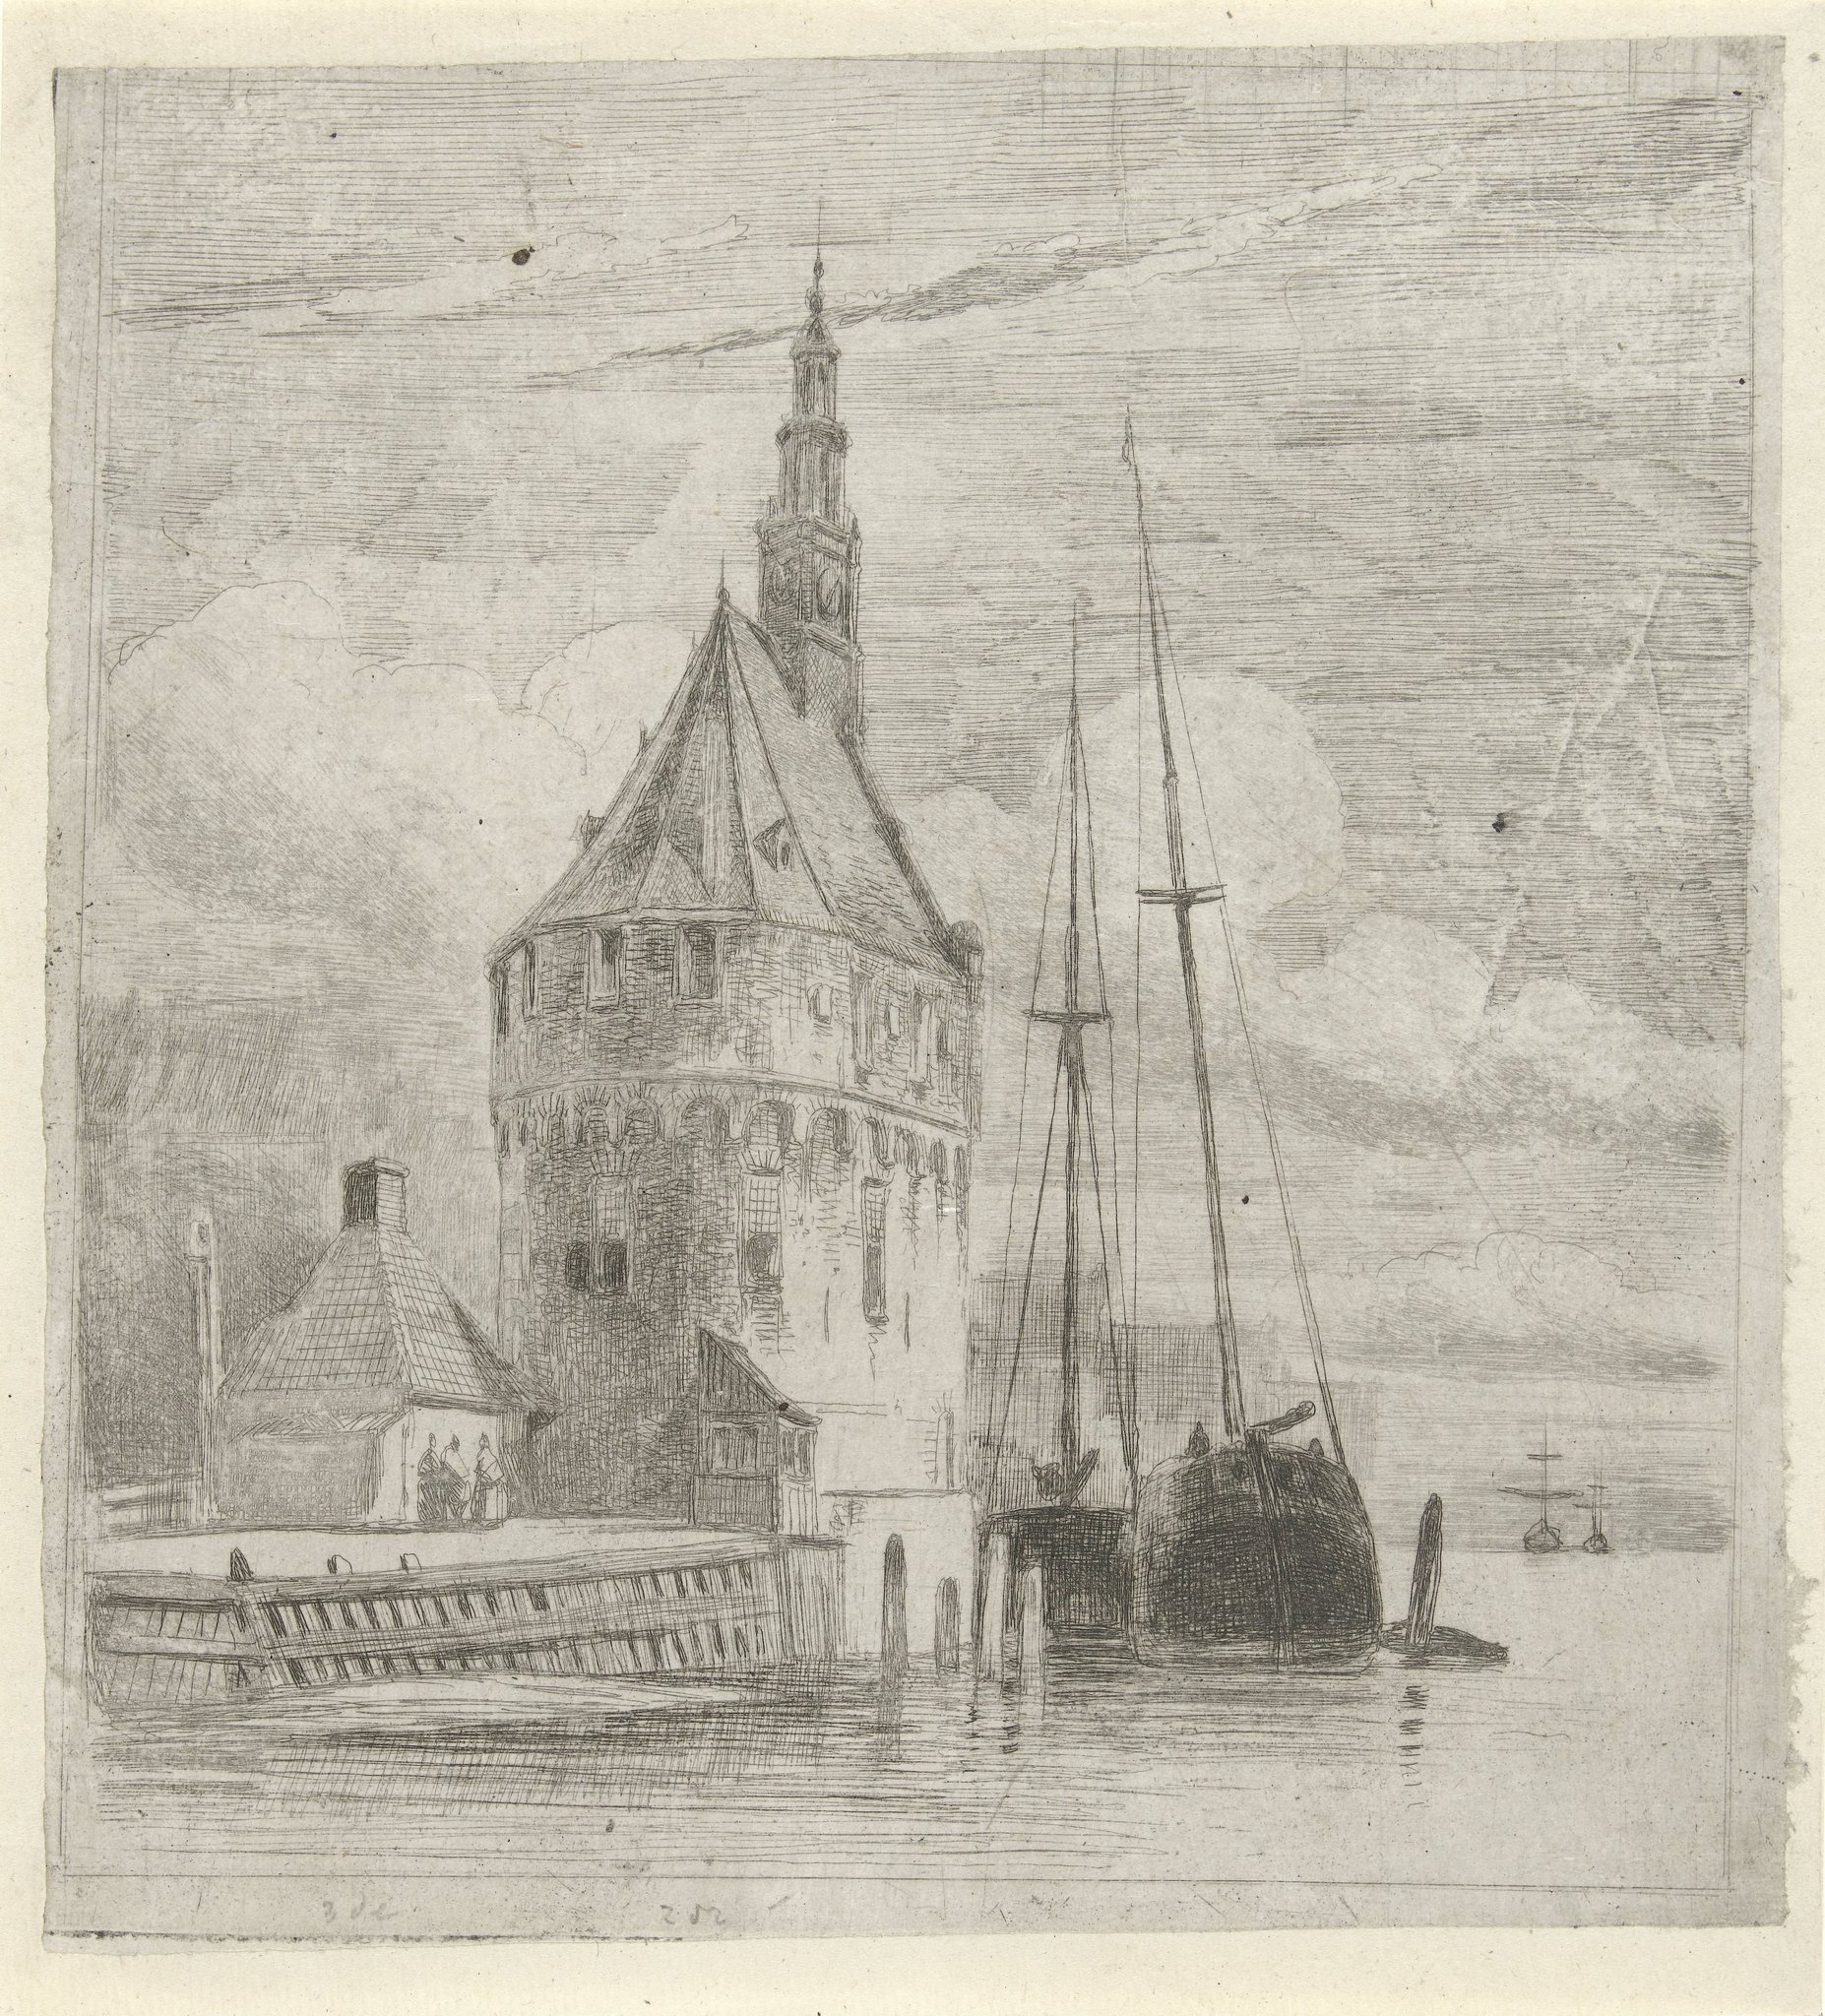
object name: print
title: Toren aan het water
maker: lambertus hardenberg (1822-1900)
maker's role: draughtsman, painter, print maker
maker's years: 1822-1900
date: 1837-1900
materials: paper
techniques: etching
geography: the hague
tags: tower, clock tower ~ monumental adornment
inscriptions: number: ‘No. 136’, collector's mark: Lugt 2228